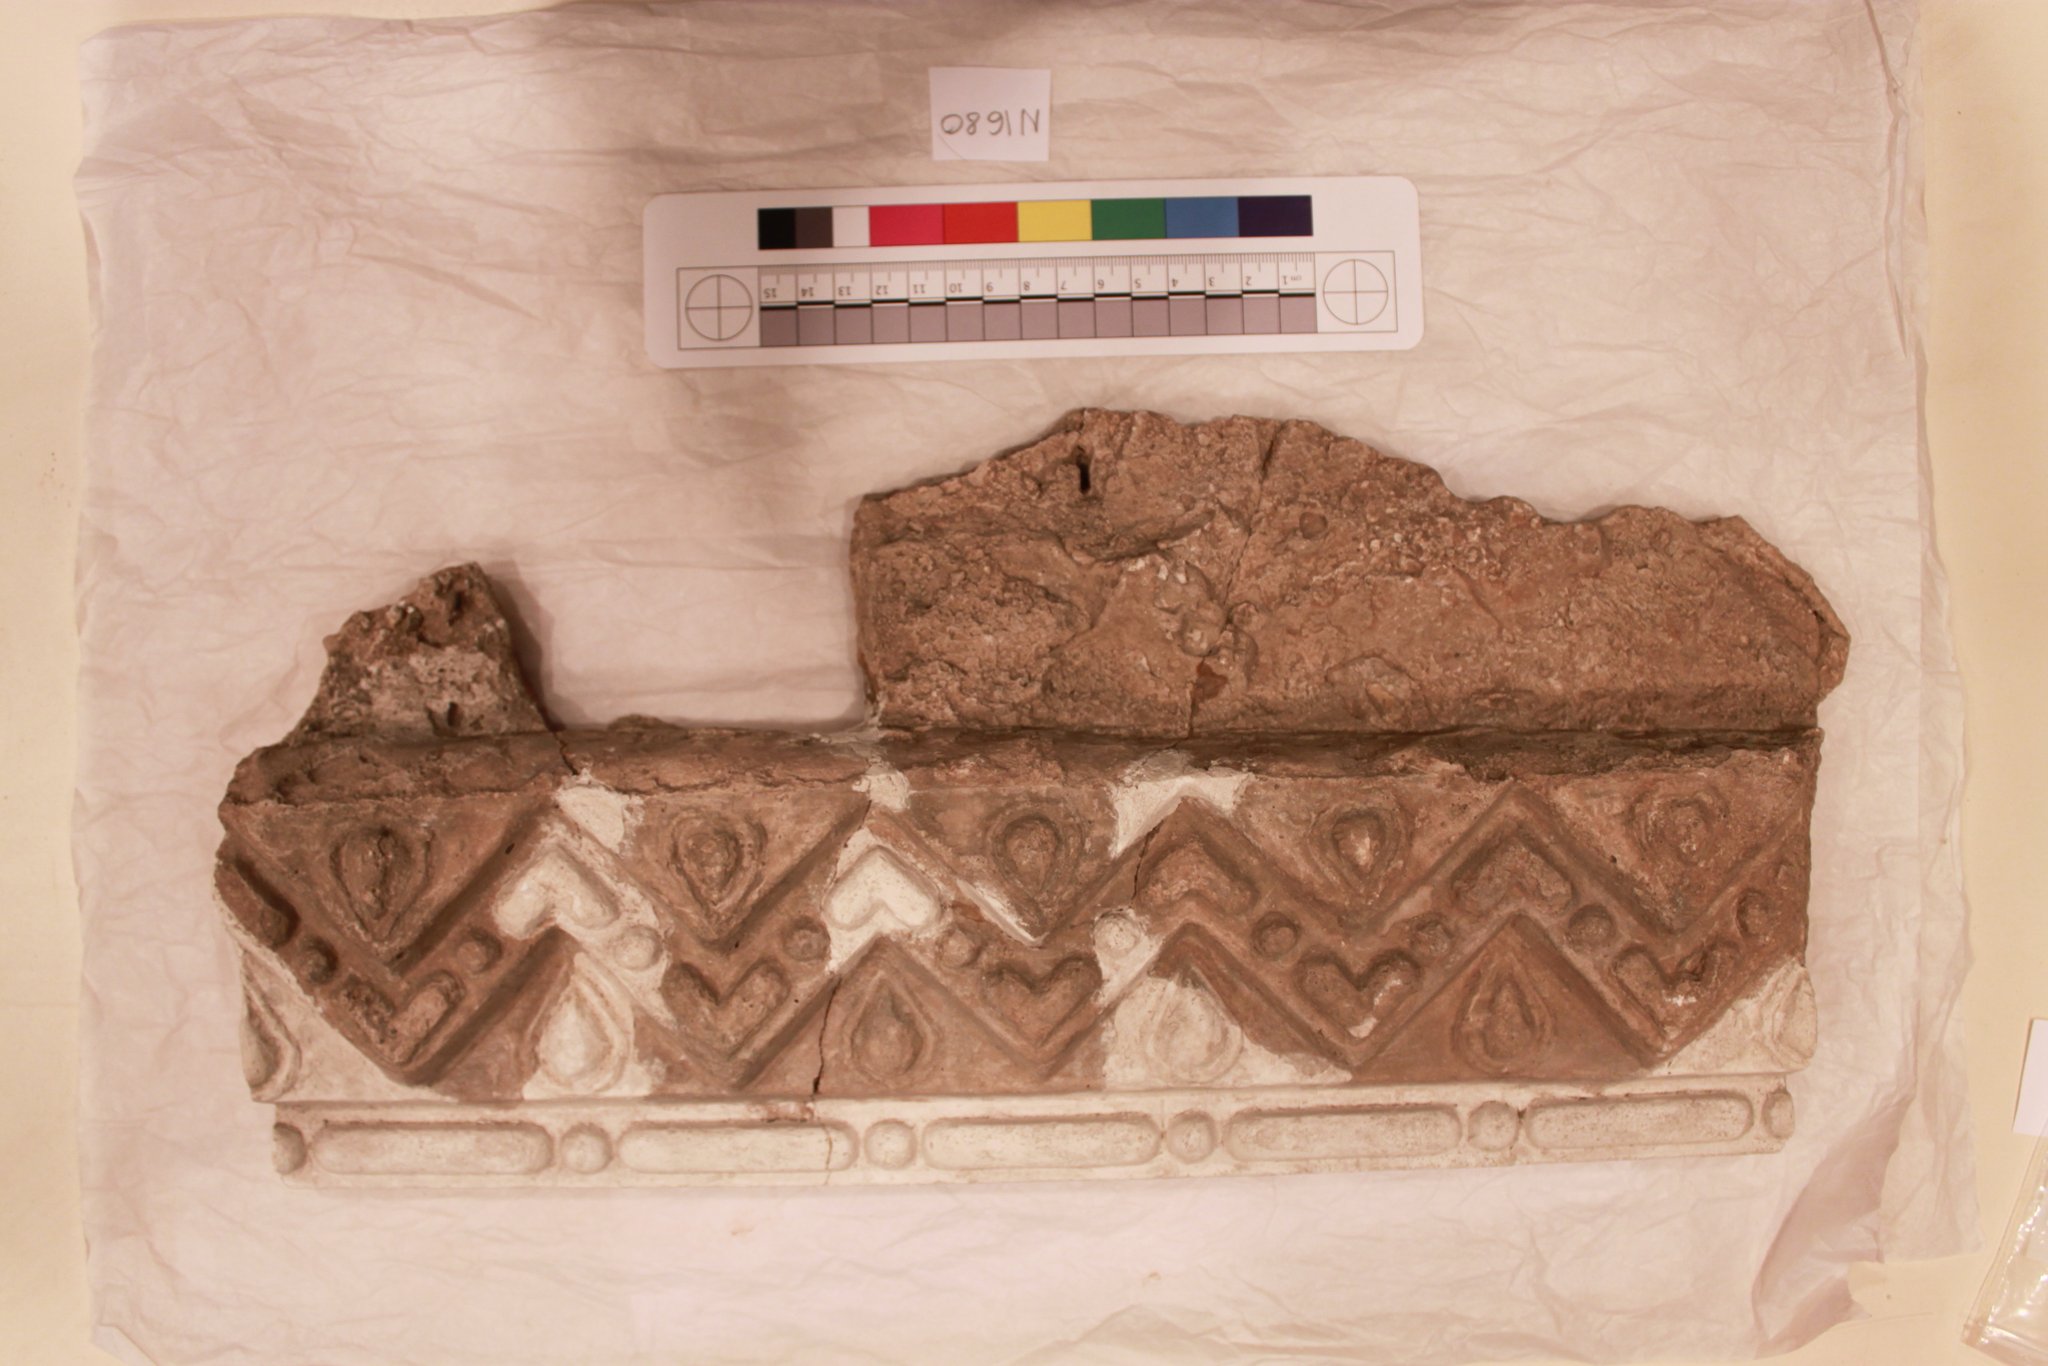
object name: fragment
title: Stucco Fragment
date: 701-1200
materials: plaster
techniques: backing, carving, molding, painting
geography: iran